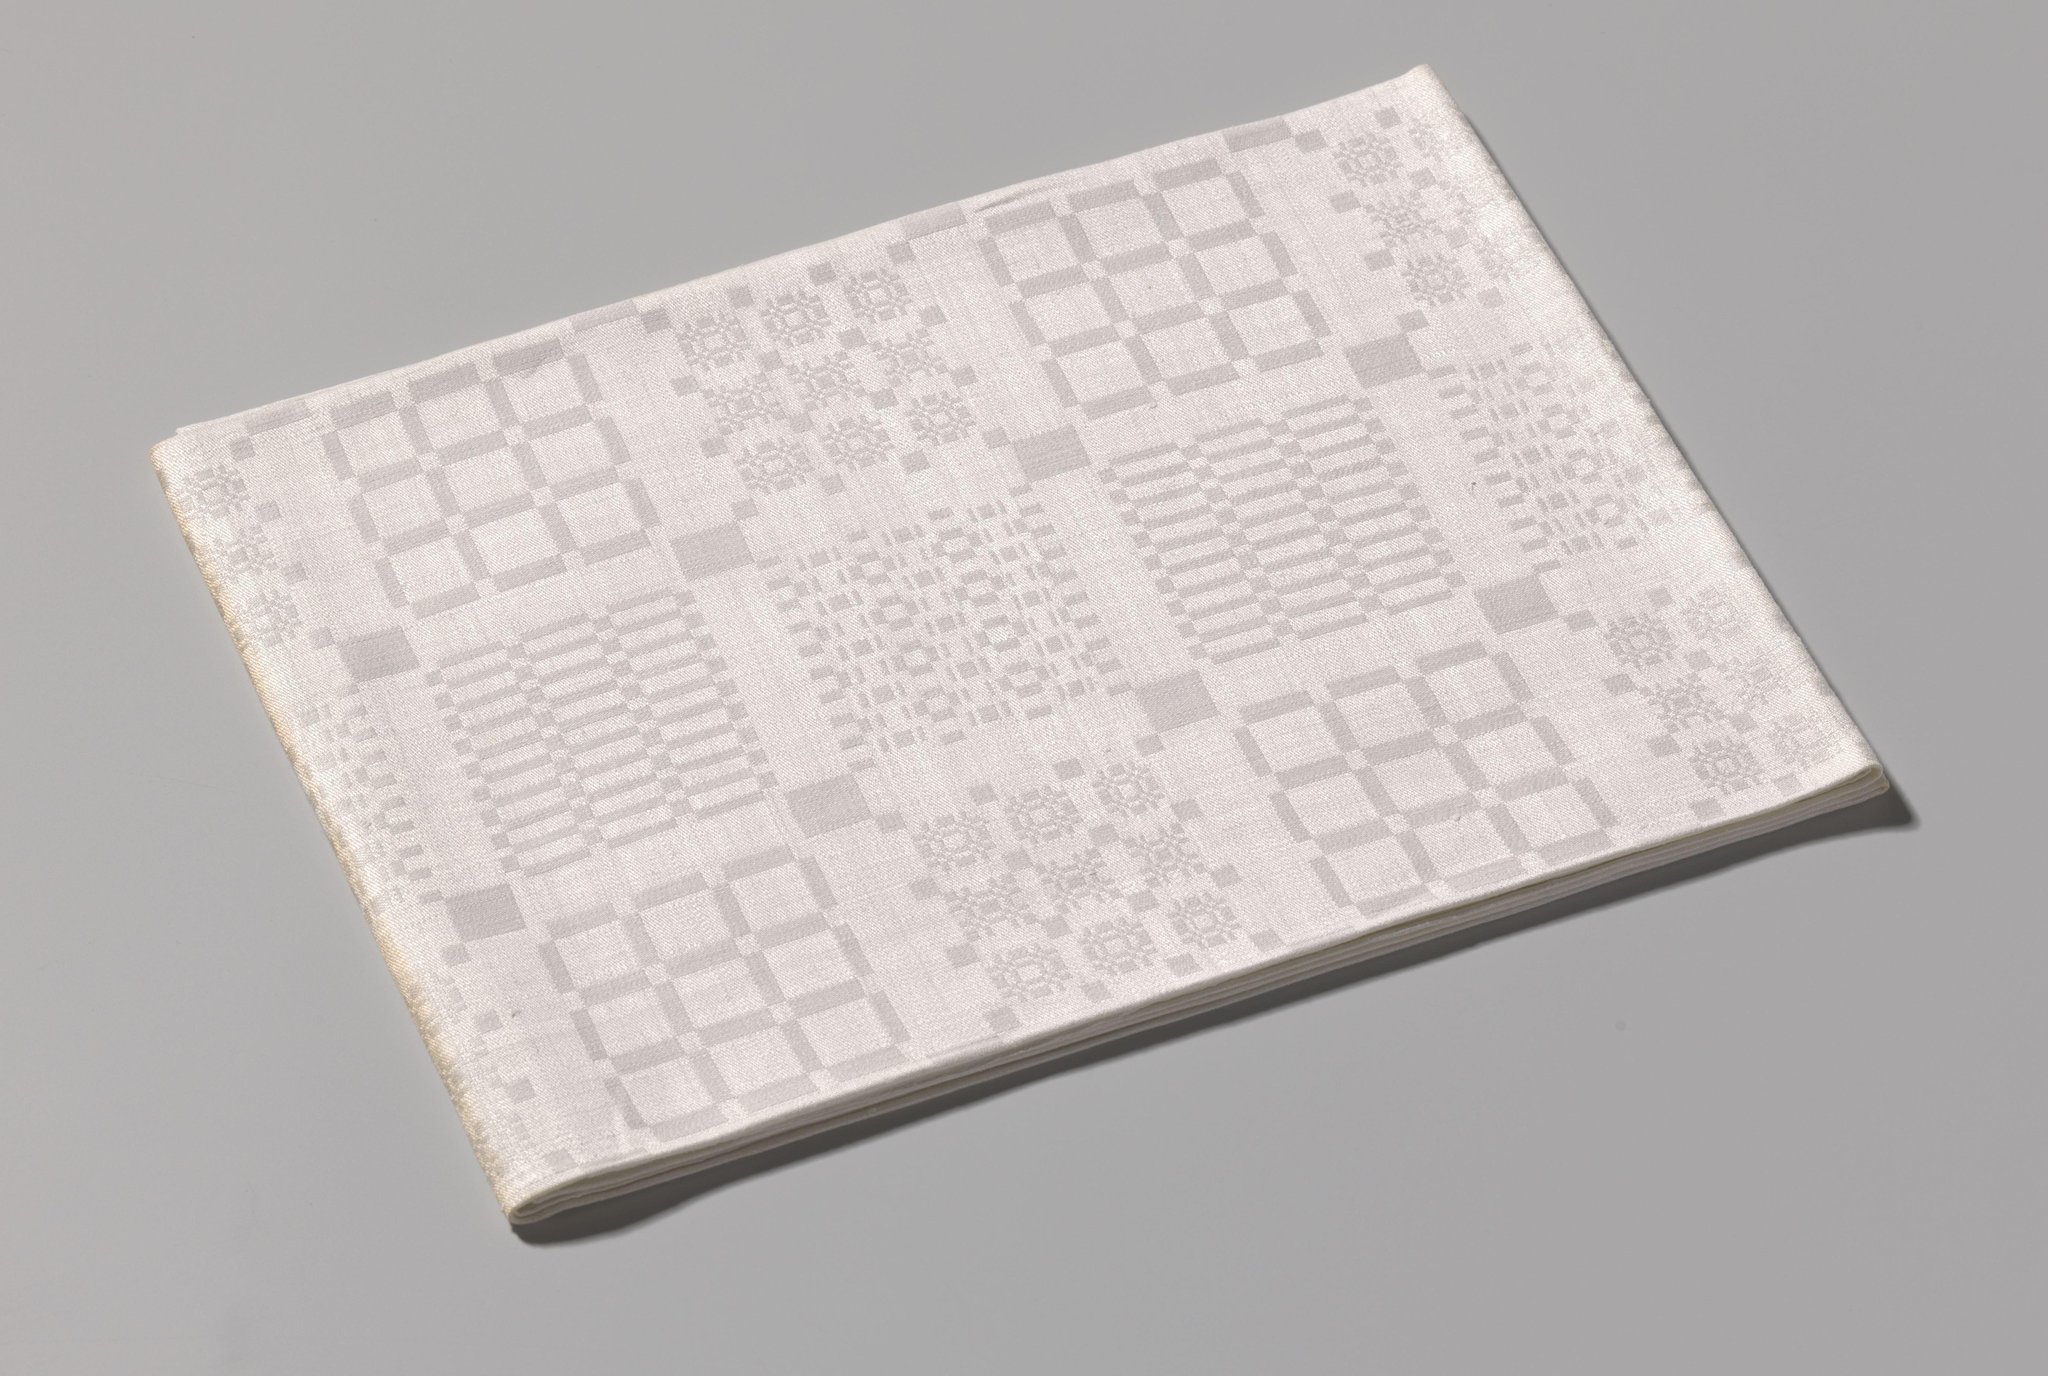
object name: napkin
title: Servet van linnen met pellenpatroon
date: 1737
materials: linen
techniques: peeled fabric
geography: northern netherlands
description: Wit linnen servet met pellenpatroon, genaamd "Oostindische caracters". Merk kroon WG 36 1737.